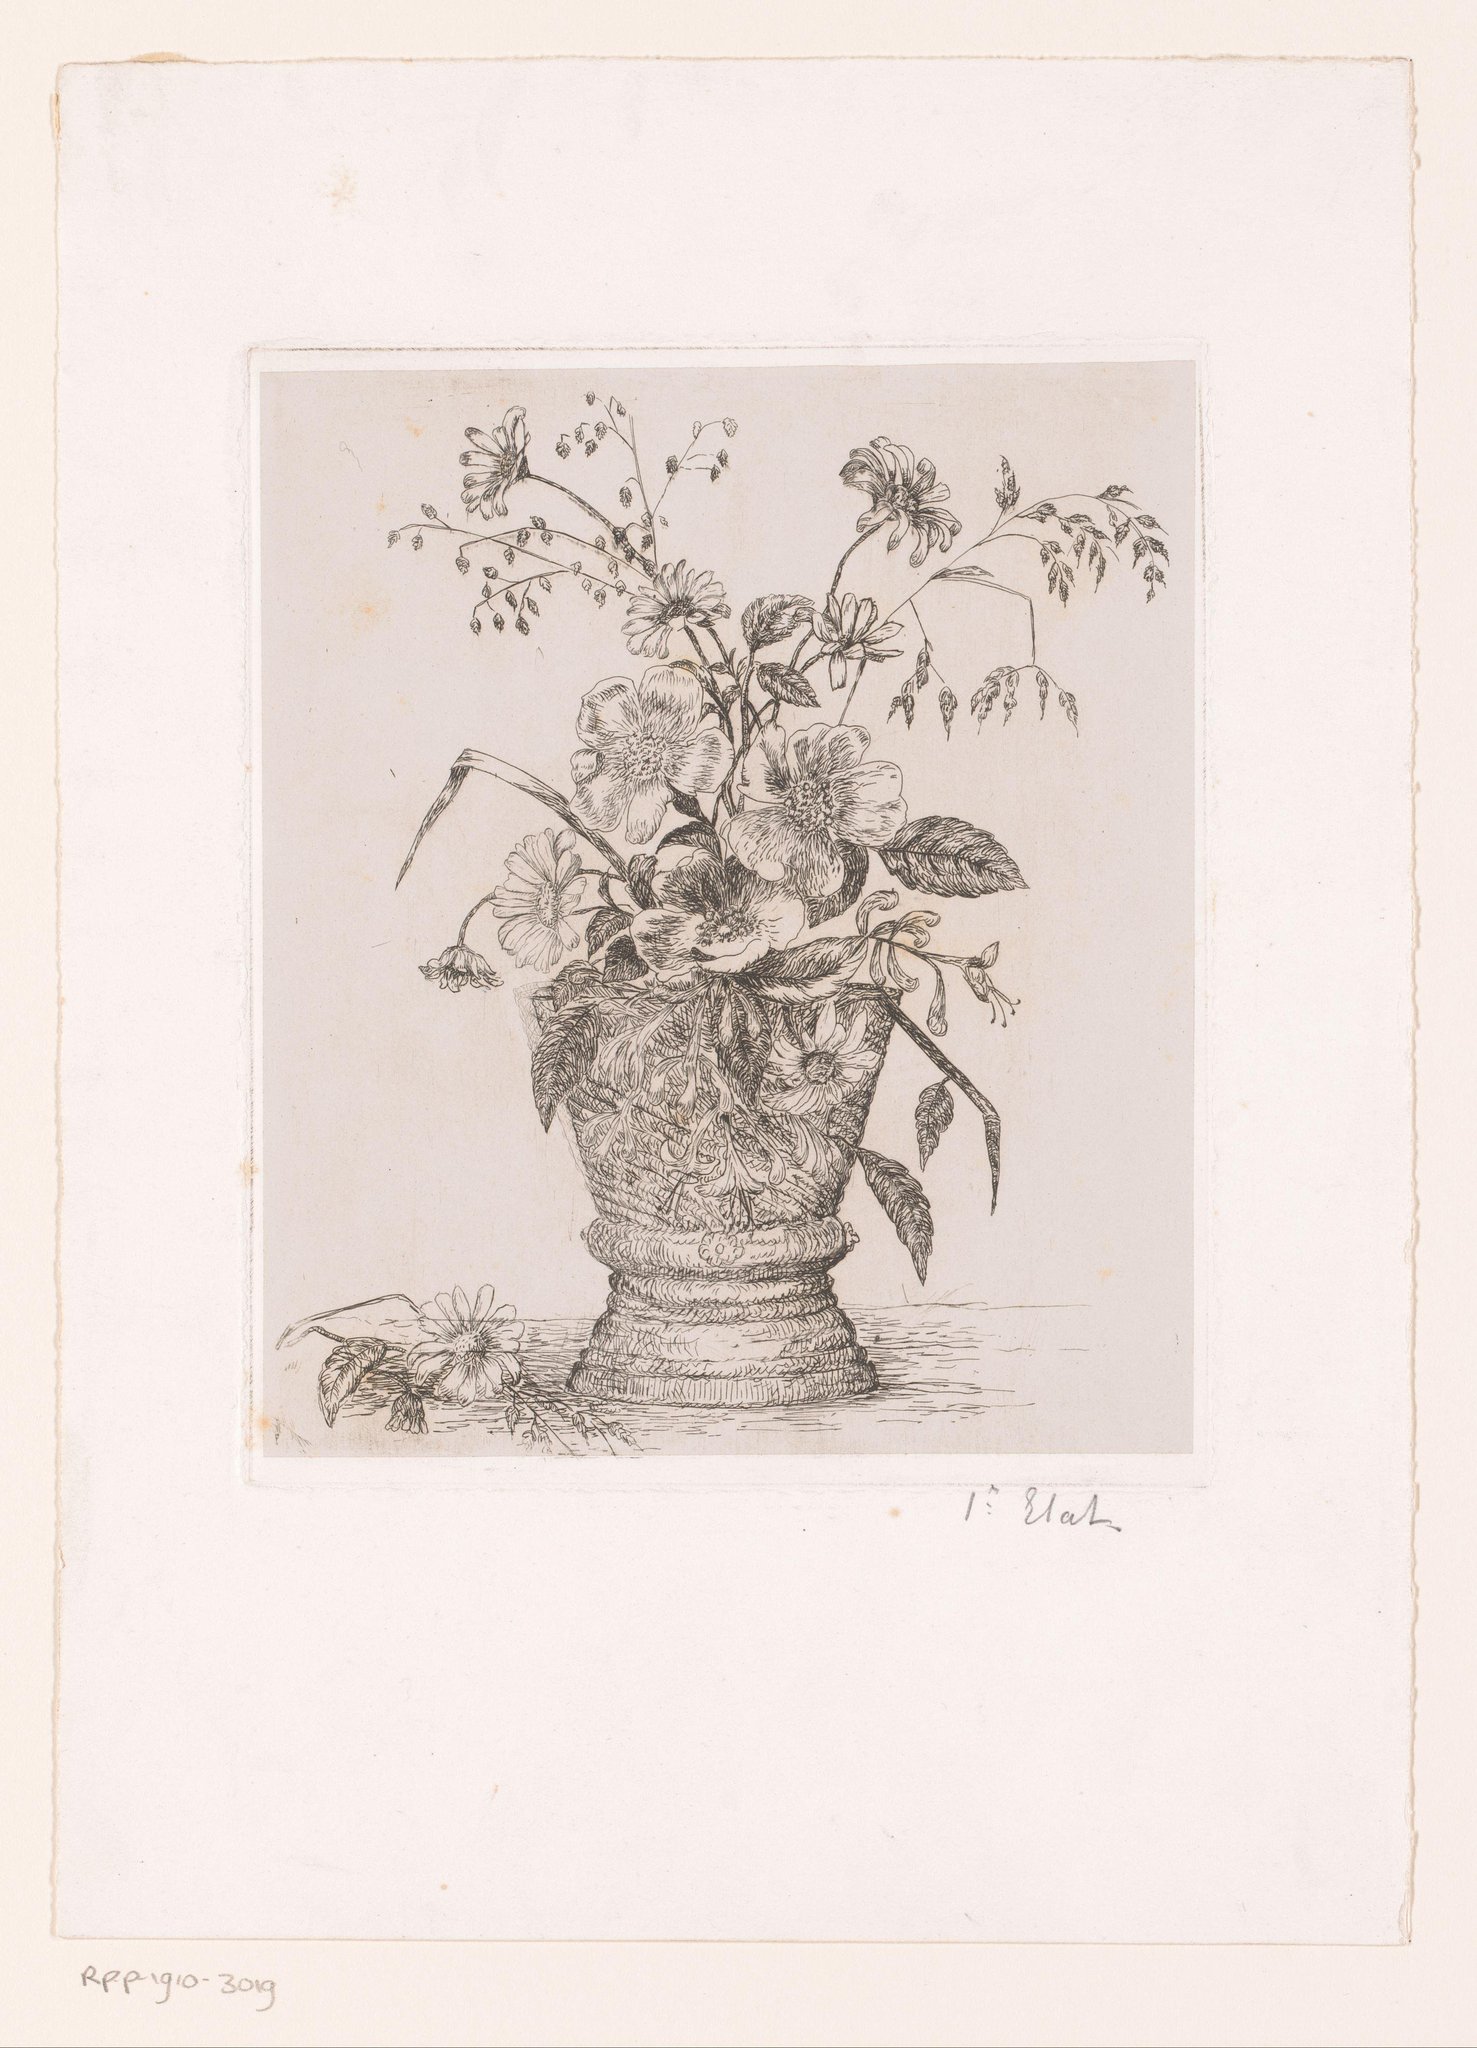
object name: print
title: Bloemen in een vaas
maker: louise elsen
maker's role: print maker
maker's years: 1853-1937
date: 1880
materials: paper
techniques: etching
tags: flowers, flowers in a vase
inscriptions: collector's mark: Lugt 2228, inscription: ‘1e Etat’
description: Diverse bloemen in een vaas. Links naast de vaas ligt nog een bloem.